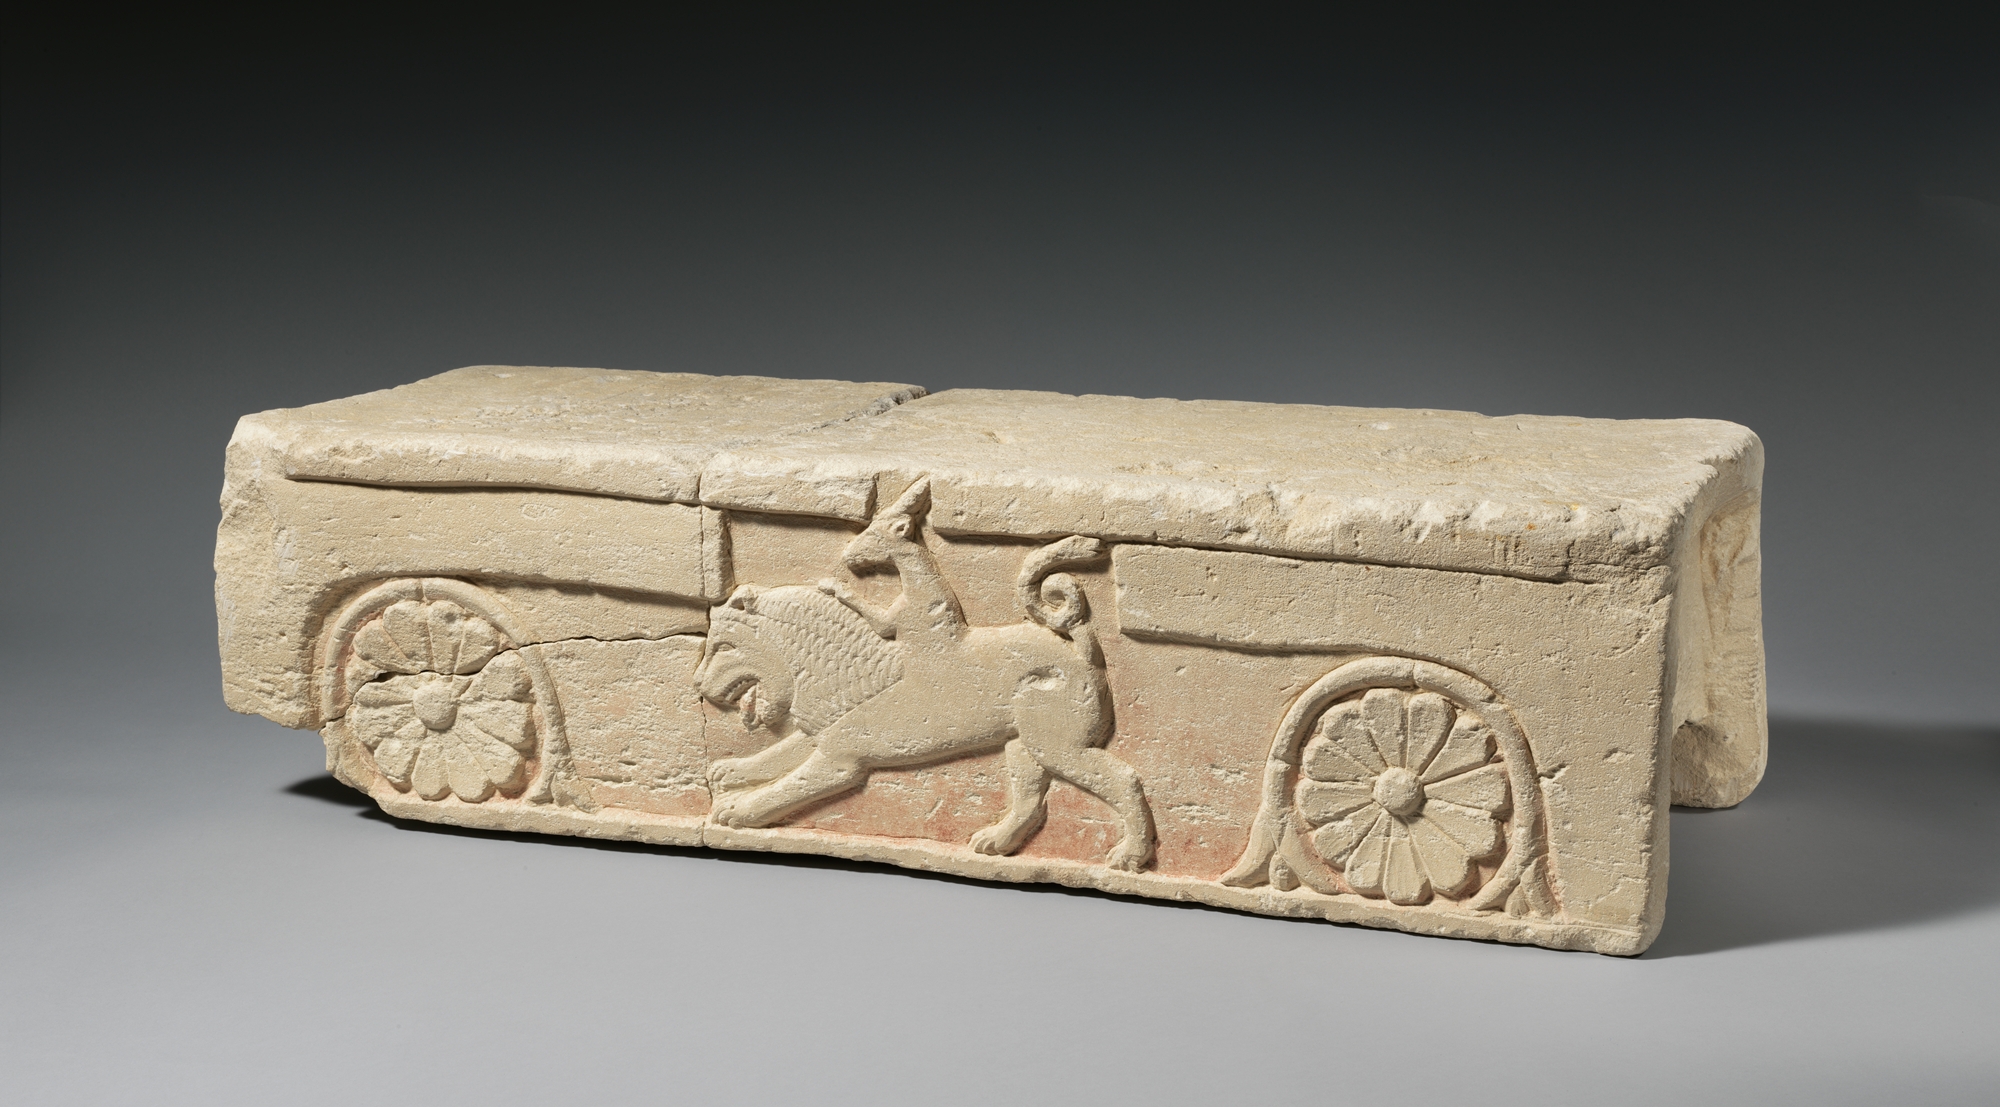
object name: step or stool of throne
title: Limestone footstool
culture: cypriot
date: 500-451 BCE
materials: limestone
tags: goats,lions,snakes,stools